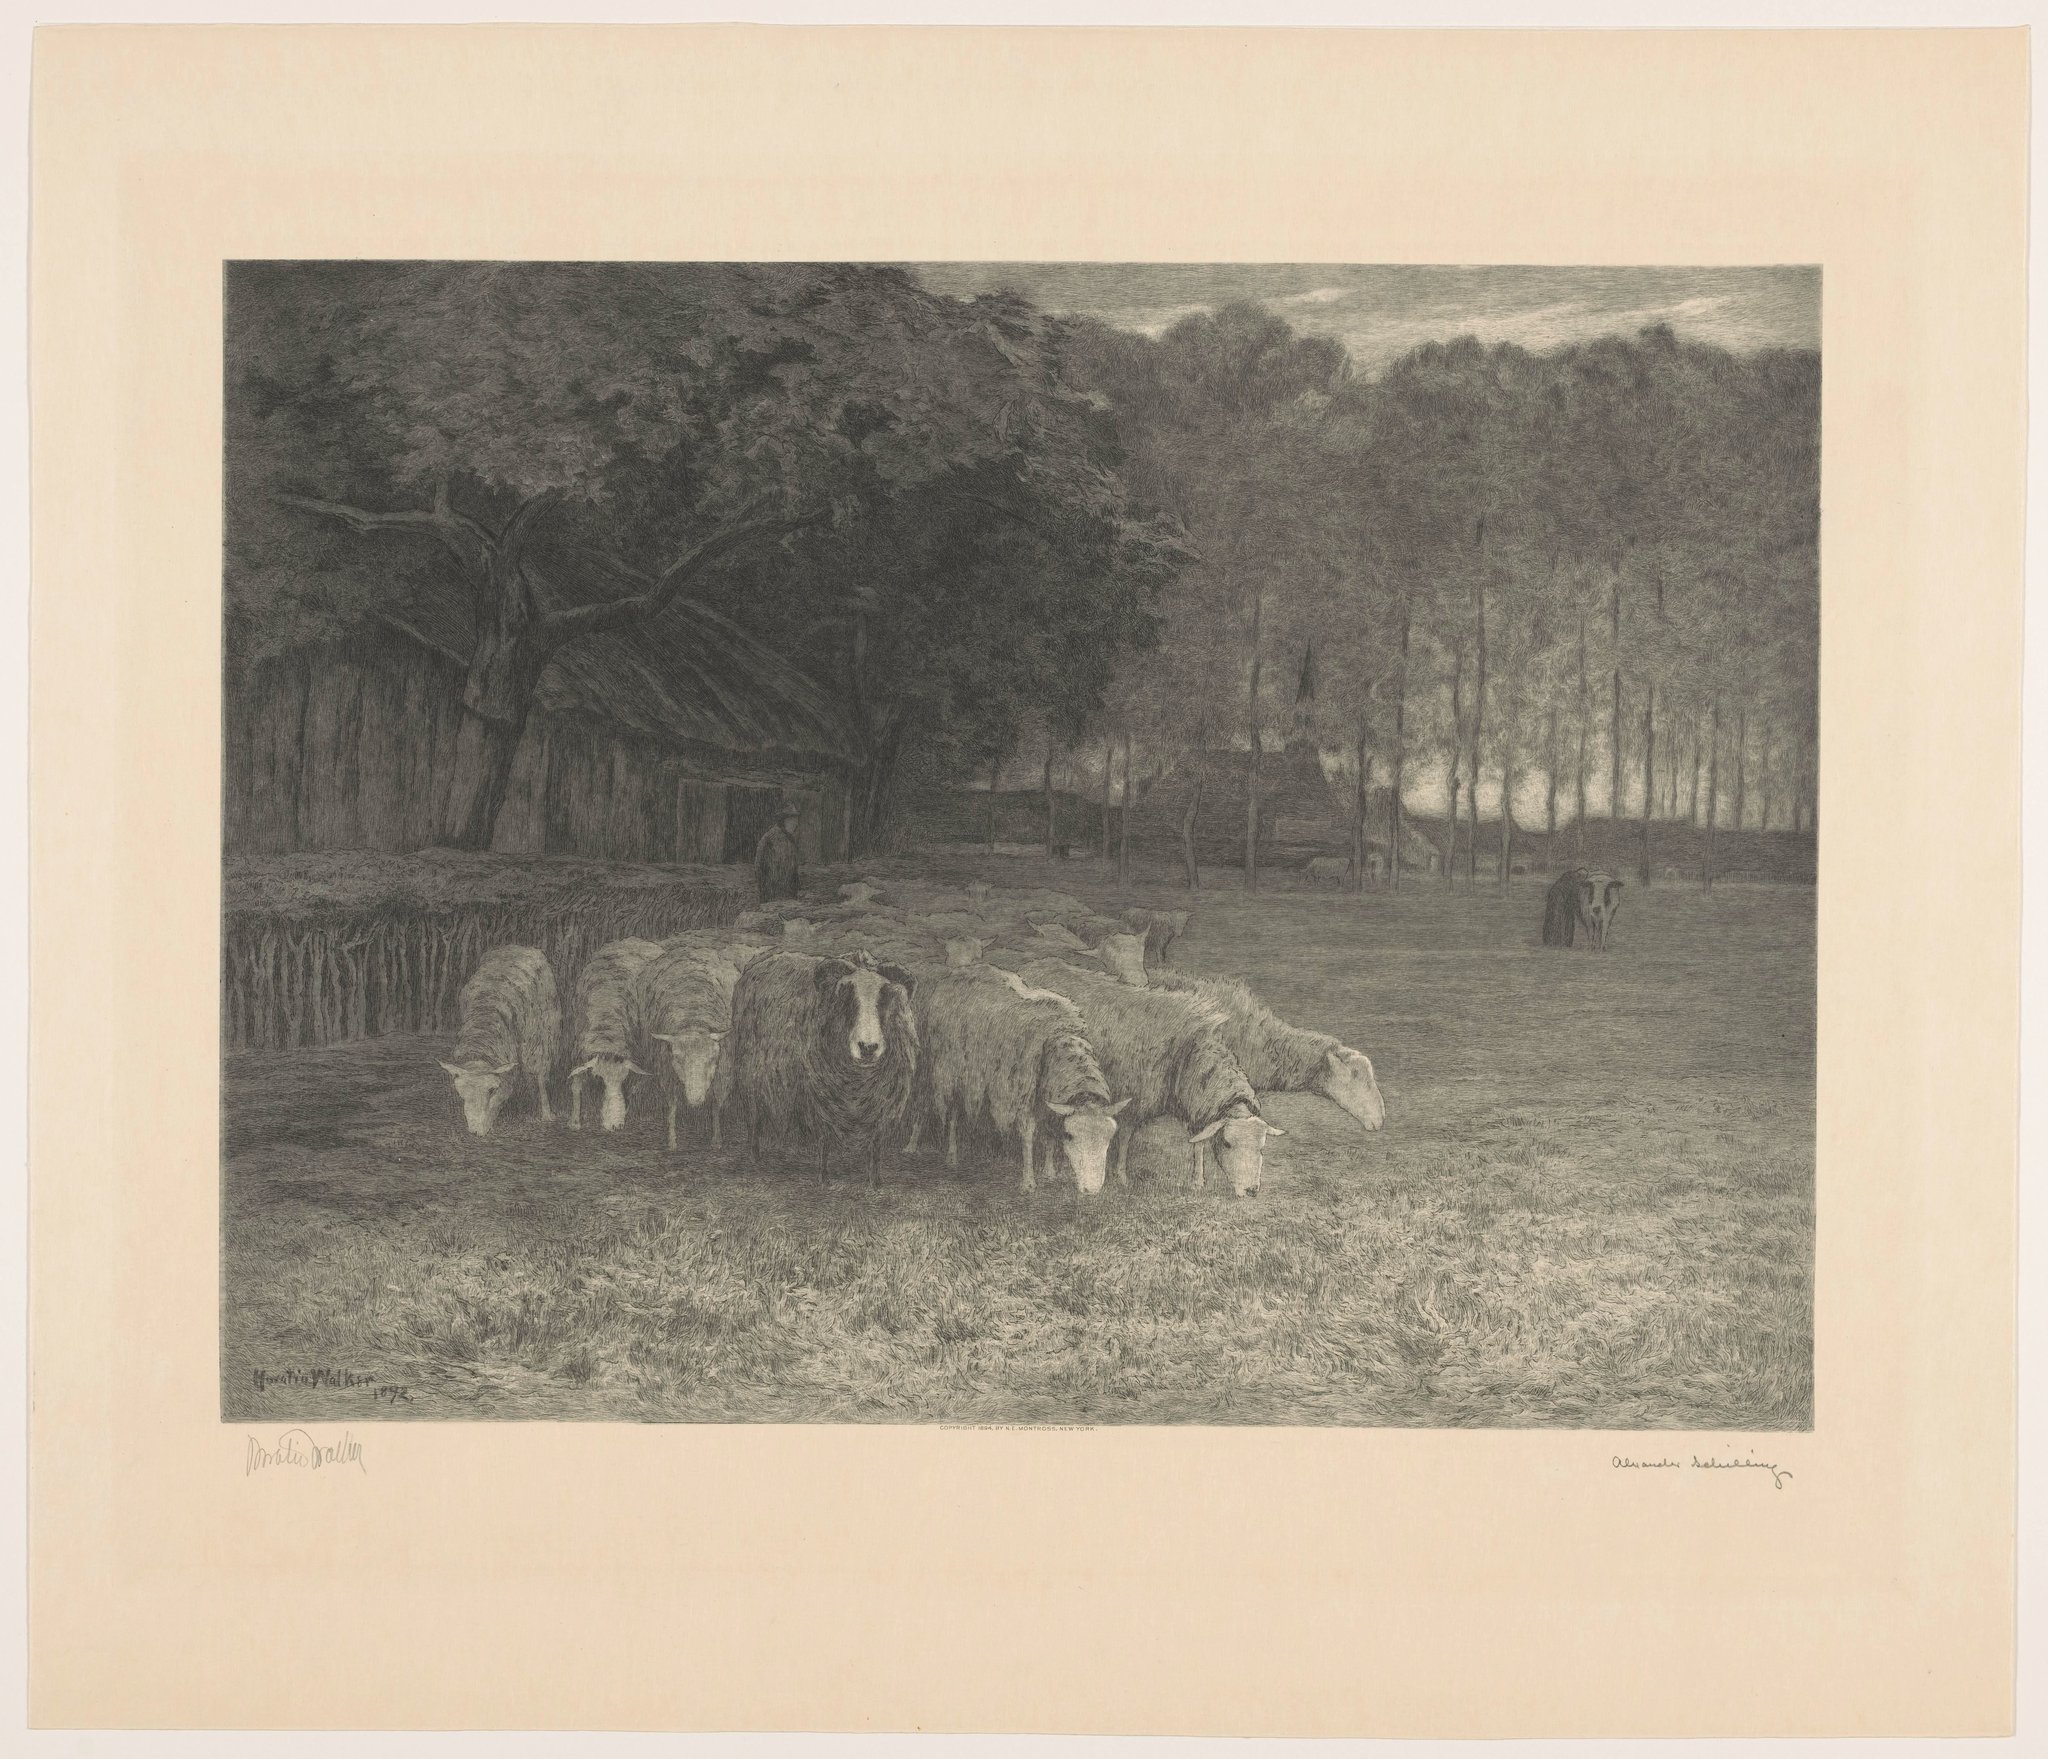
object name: print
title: Landschap met boerderijen en schapen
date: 1894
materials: paper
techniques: drypoint, etching, intaglio, retroussage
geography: new york city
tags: landscapes, sheep, farm or solitary house in landscape, farm (building)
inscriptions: inscription: ‘Geschenk van den Heer. K.H. de Haas / te Rotterdam’, collector's mark: Lugt 2228